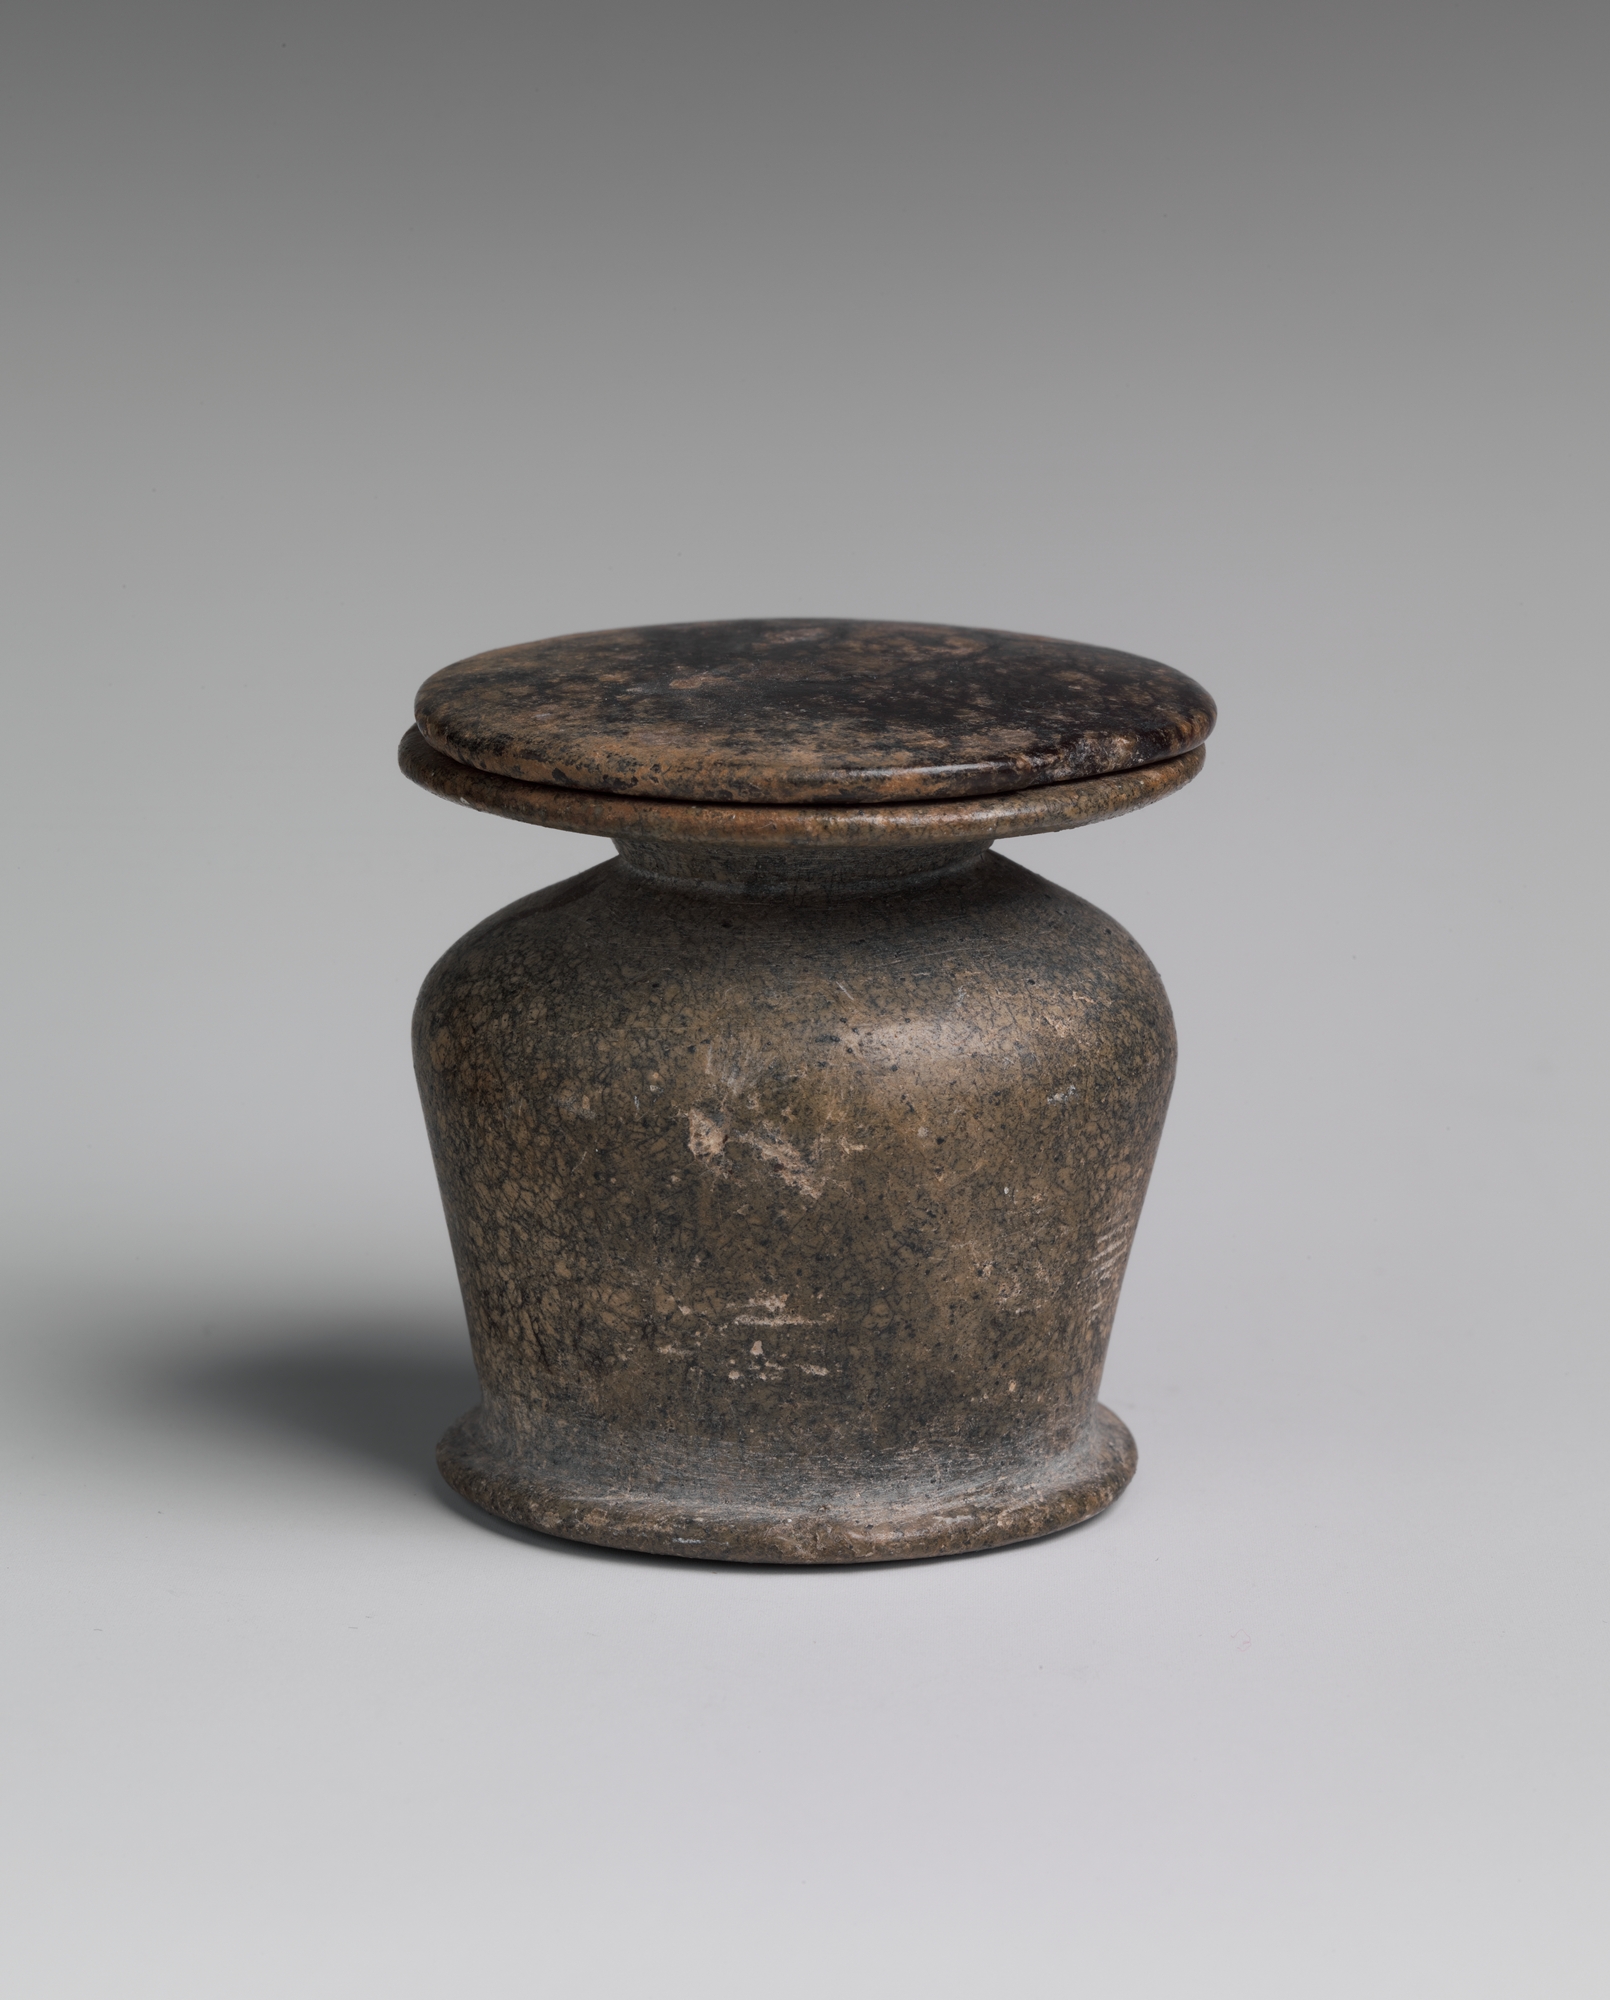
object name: kohl jar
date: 1550-1458 BCE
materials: stone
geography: egypt